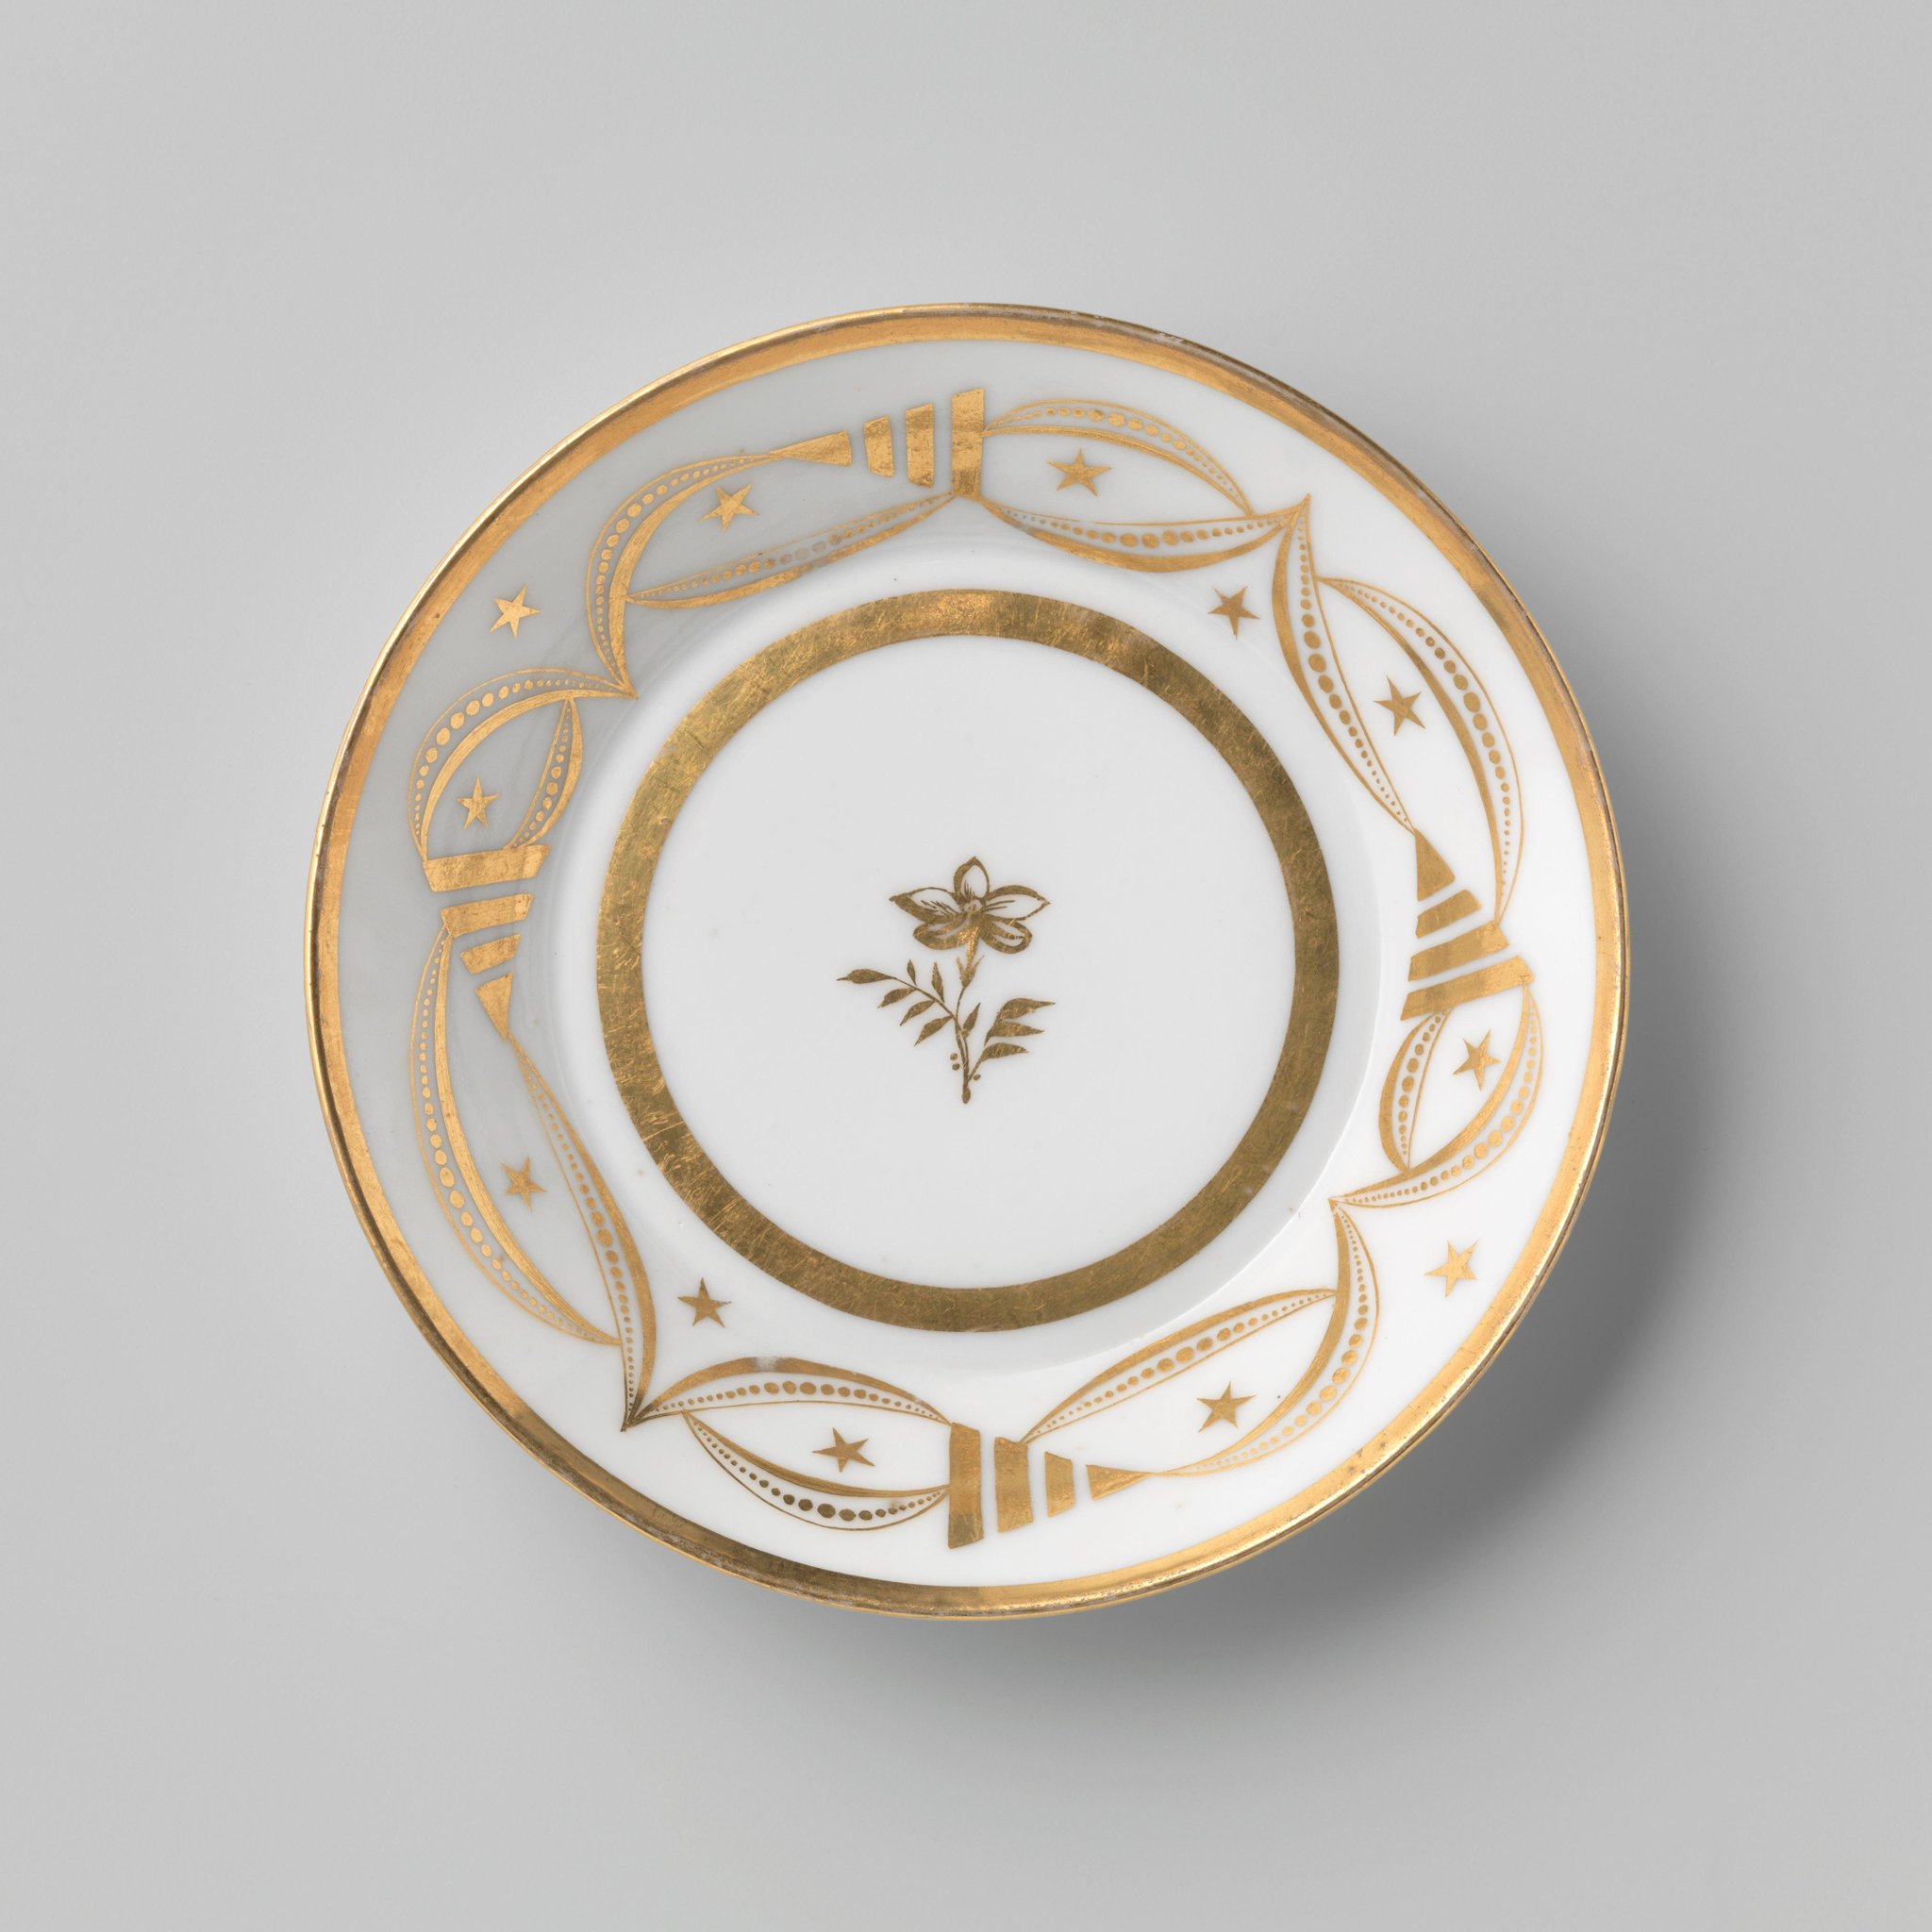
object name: platter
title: Saucer with an ornamental border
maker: Anonymous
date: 1800-1824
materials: glaze, gold, paint, porcelain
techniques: firing, forming, gilding, turning, vitrification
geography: france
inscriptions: mark: ‘g’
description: Schotel van porselein, versierd met gouden banden waartussen een slingermotief dat wordt gevormd door halvemaanvormige schijven waarin punten. De schijven worden verbonden door driehoeken. Op de tussenliggende velden gouden sterren. Op het plat een bloemtak. Behoort tot een serie van twaalf kop-en-schotels (BK-16044-F-1-24), onderdeel van een koffie- en theeservies.